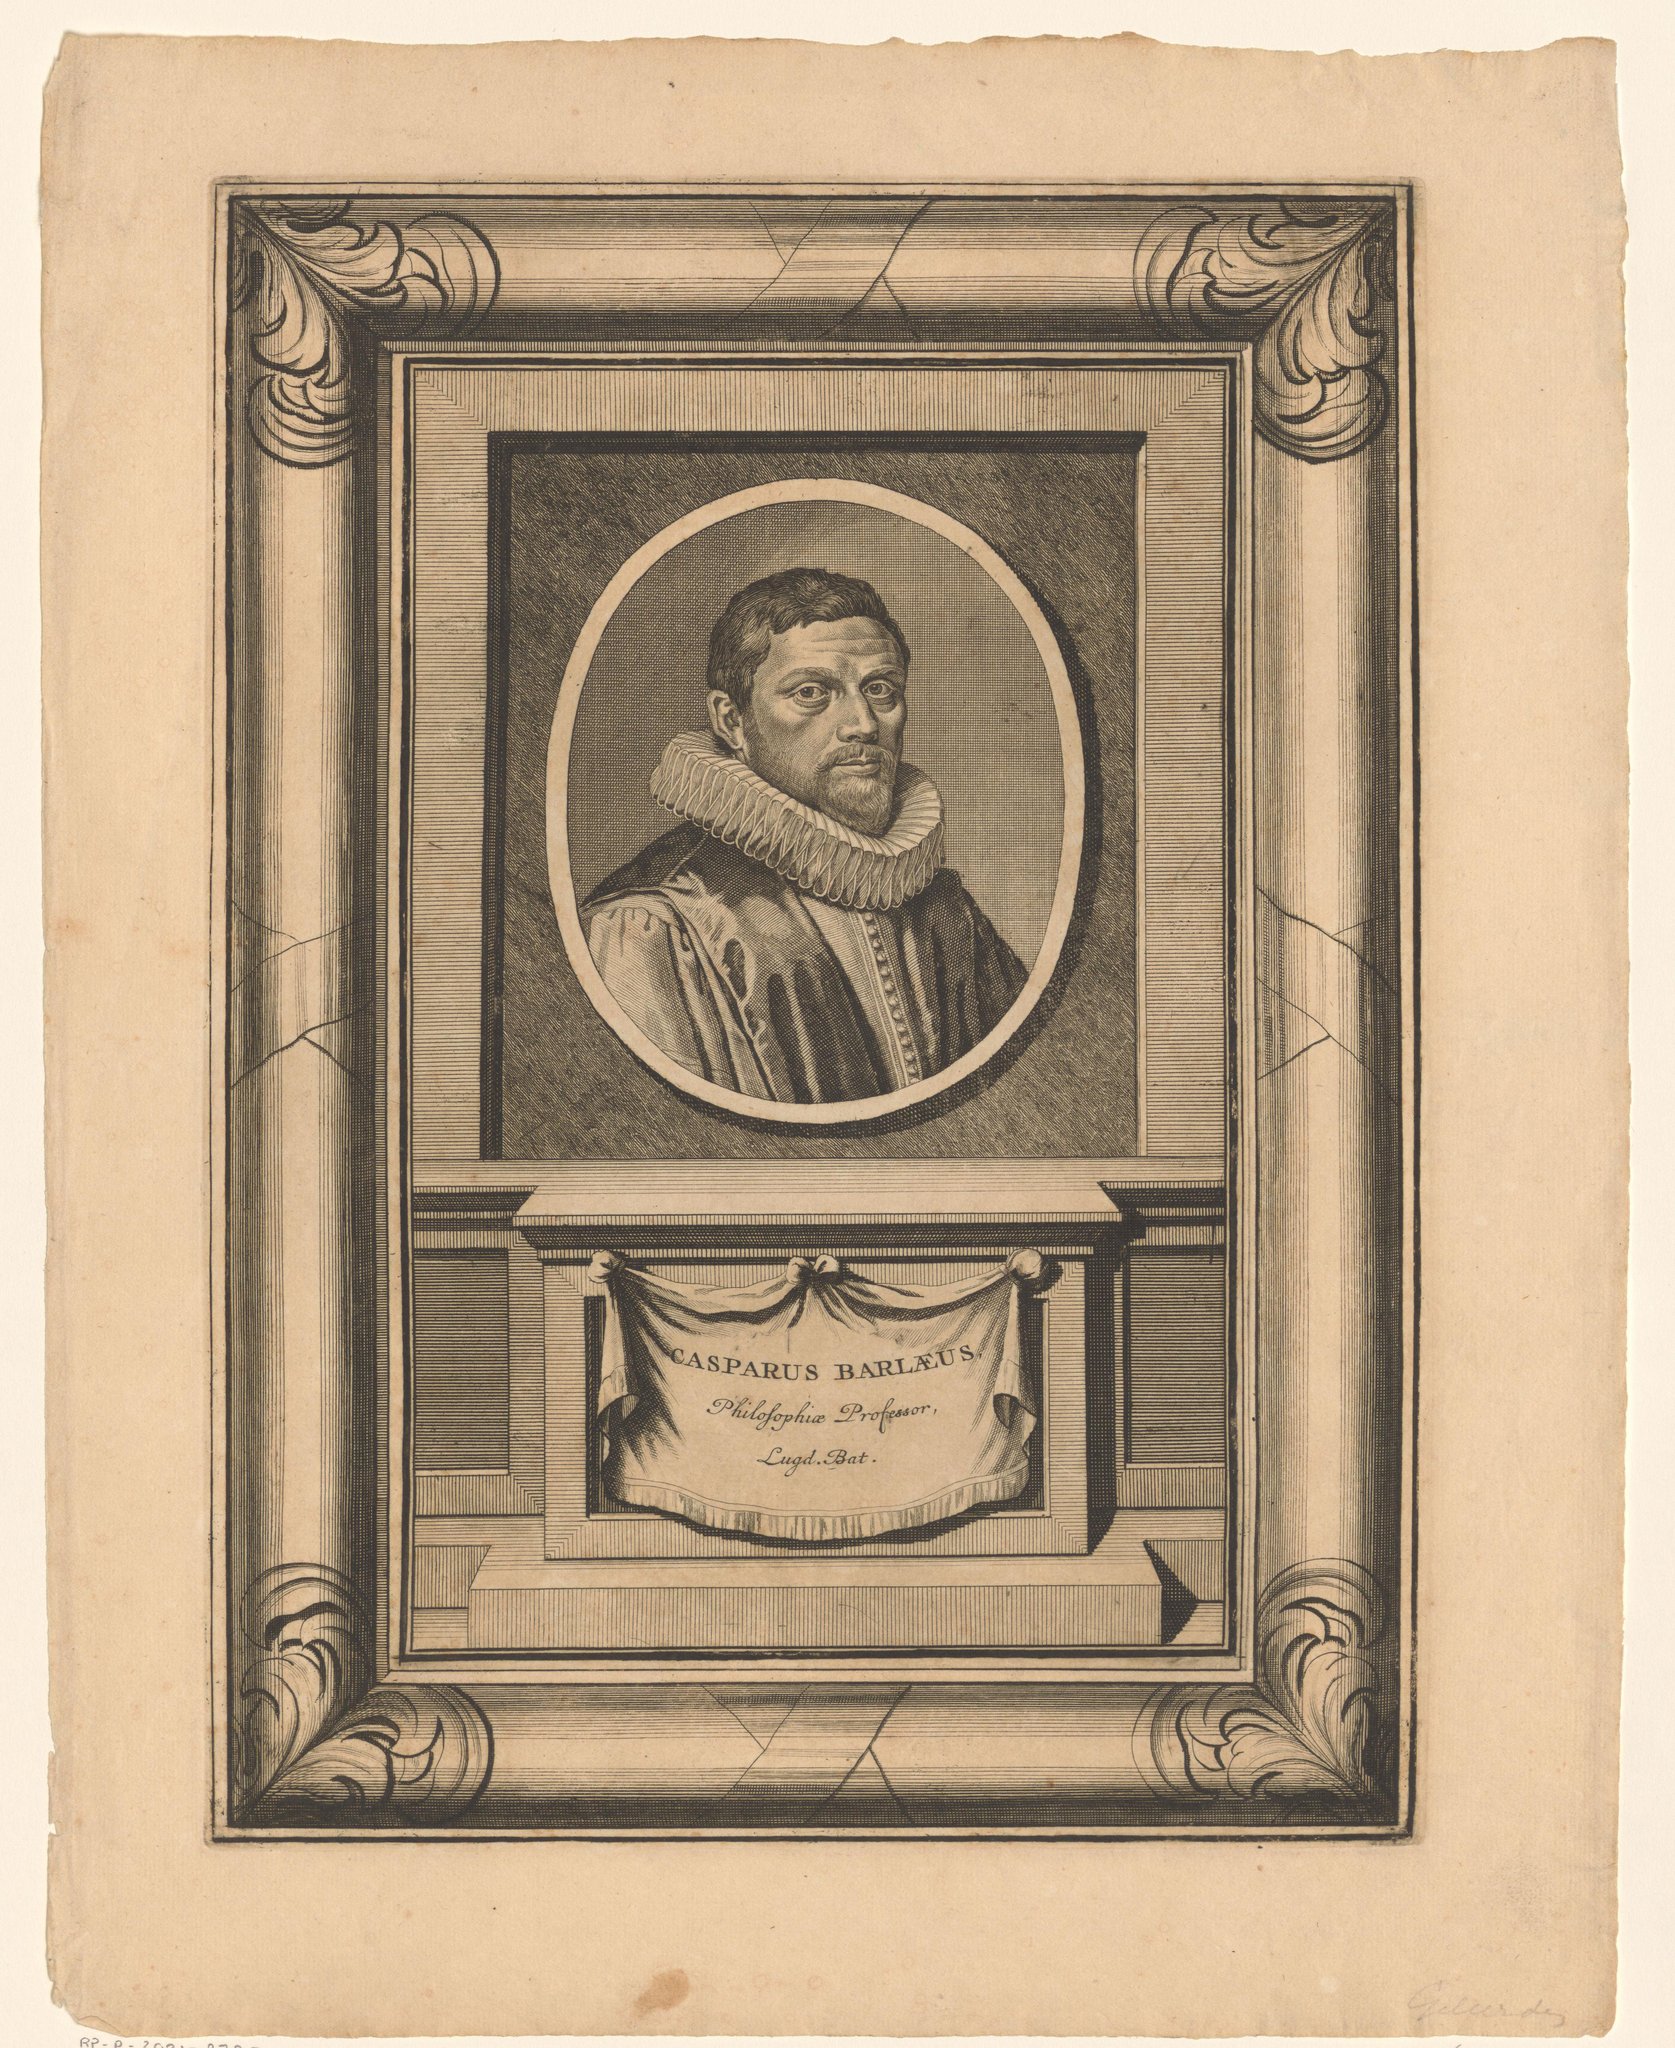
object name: print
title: Portret van Caspar van Baerle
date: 1668-1733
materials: paper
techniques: engraving, etching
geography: leiden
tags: antwerp, amsterdam, caspar van baerle, historical persons, professor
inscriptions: collector's mark: Lugt 2228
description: Prent zonder omlijsting gebruikt in: Fundatoris, curatorum et professorum celeberrimorum (...). Leiden: Pieter van der Aa, 1716.